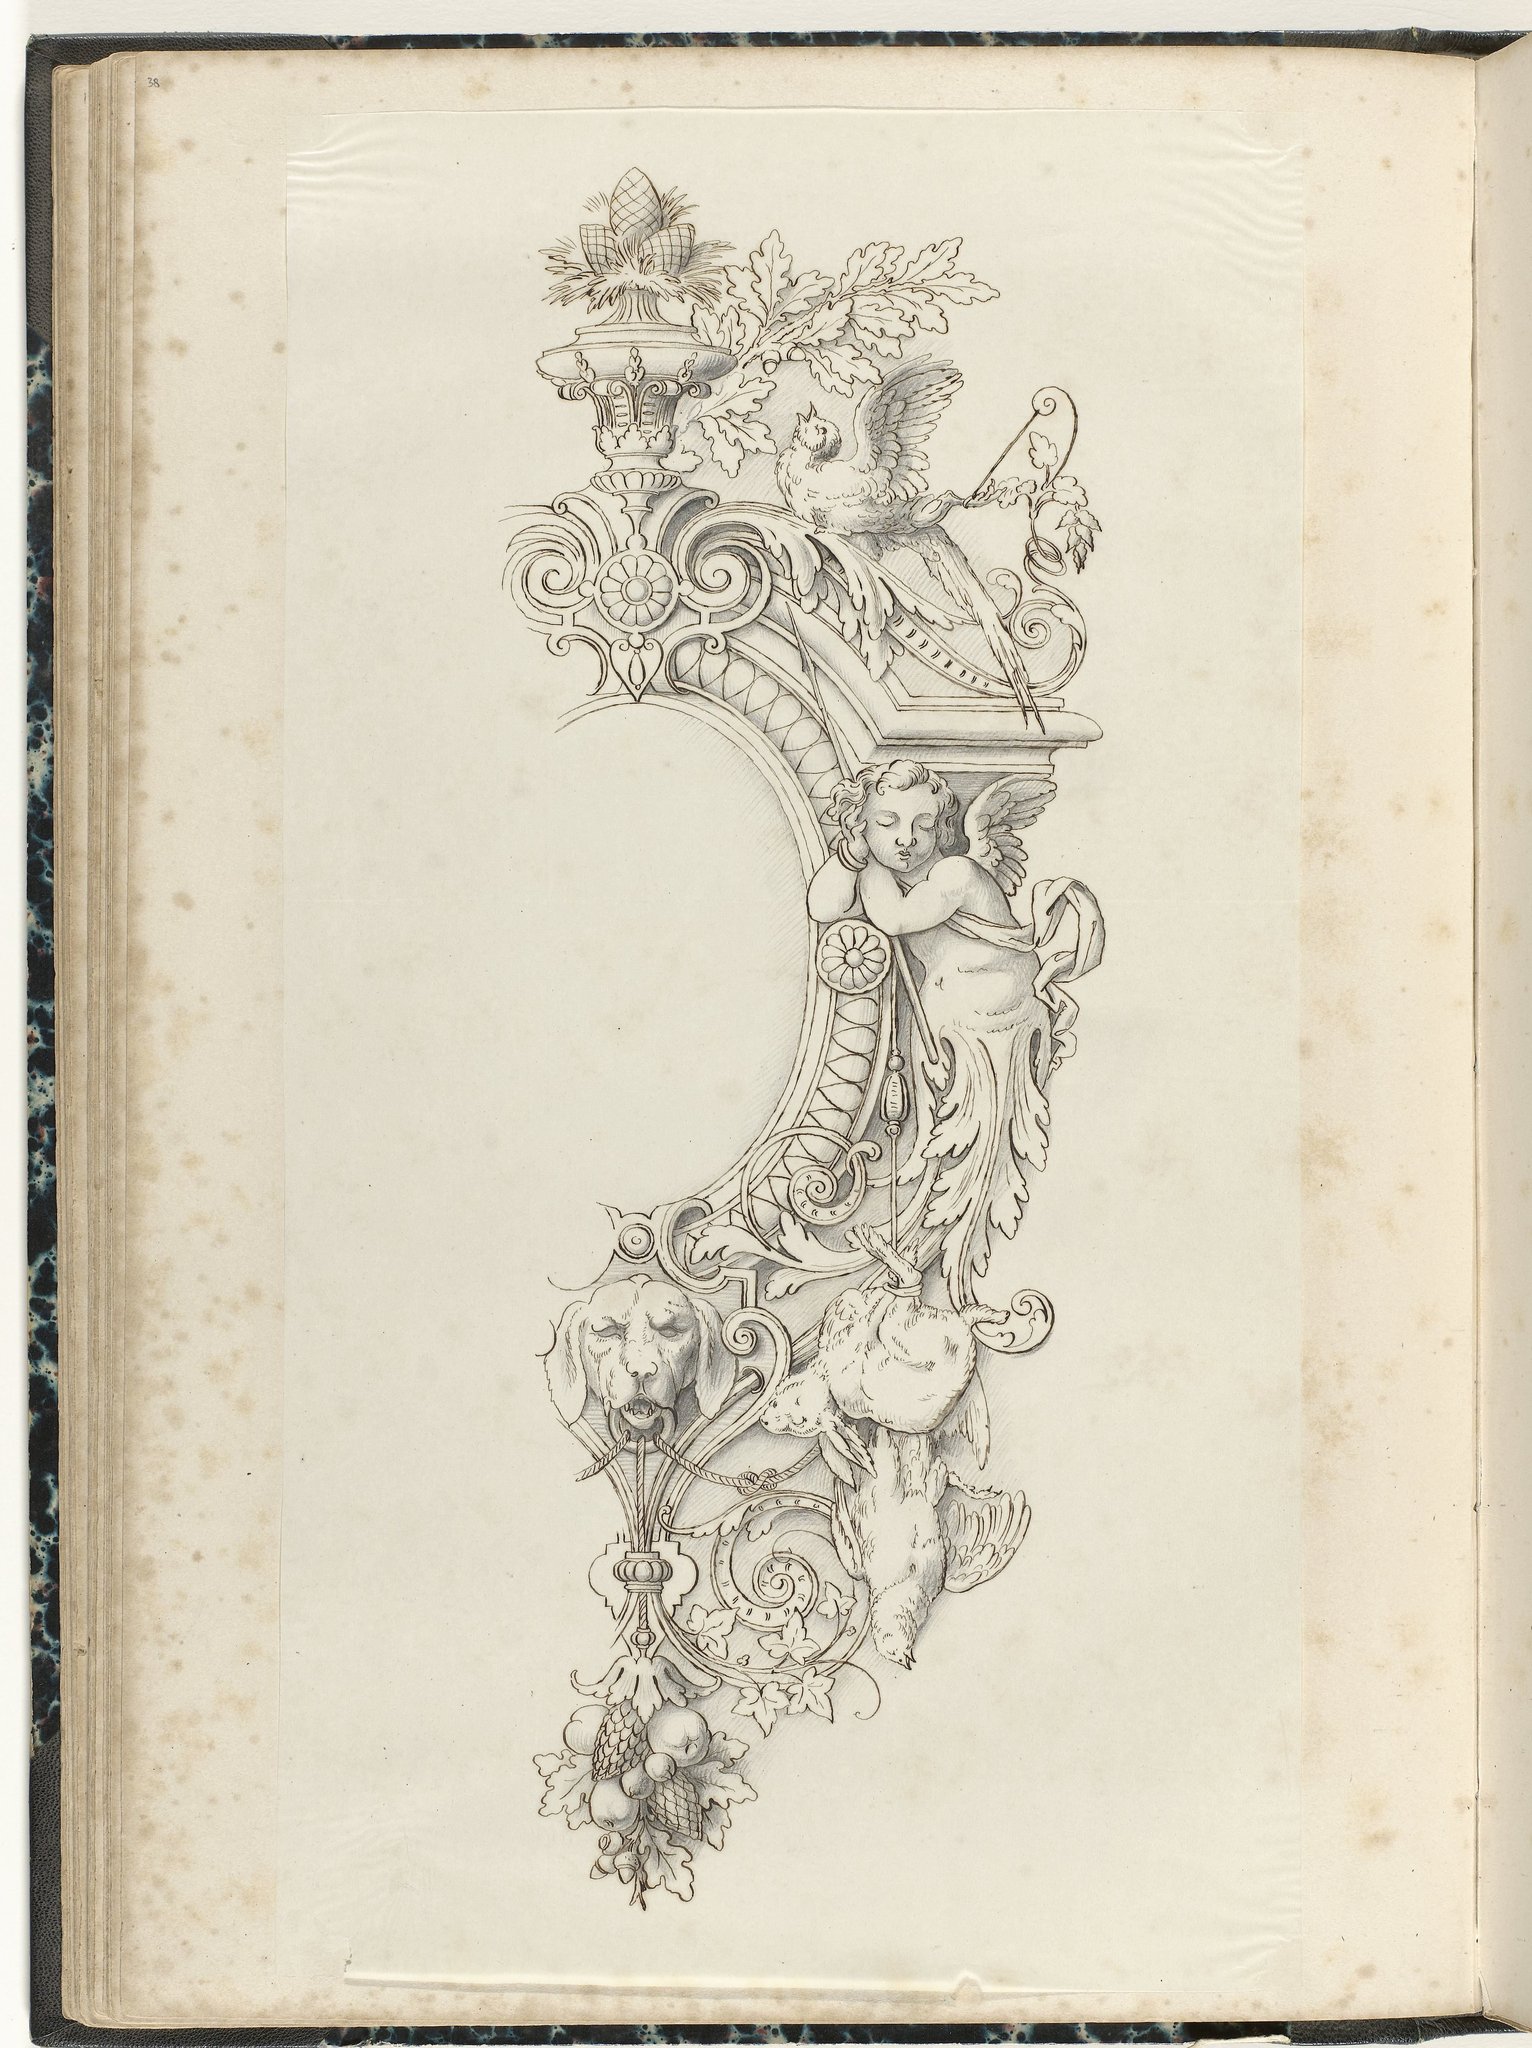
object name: drawing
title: Halve cartouche met putto en dieren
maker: Anonymous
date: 1866-1900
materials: ink, pencil, paper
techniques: drawing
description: Het onderlichaam van de putto loopt uit in bladranken, onderaan de cartouche bevindt zich een hondenkop.